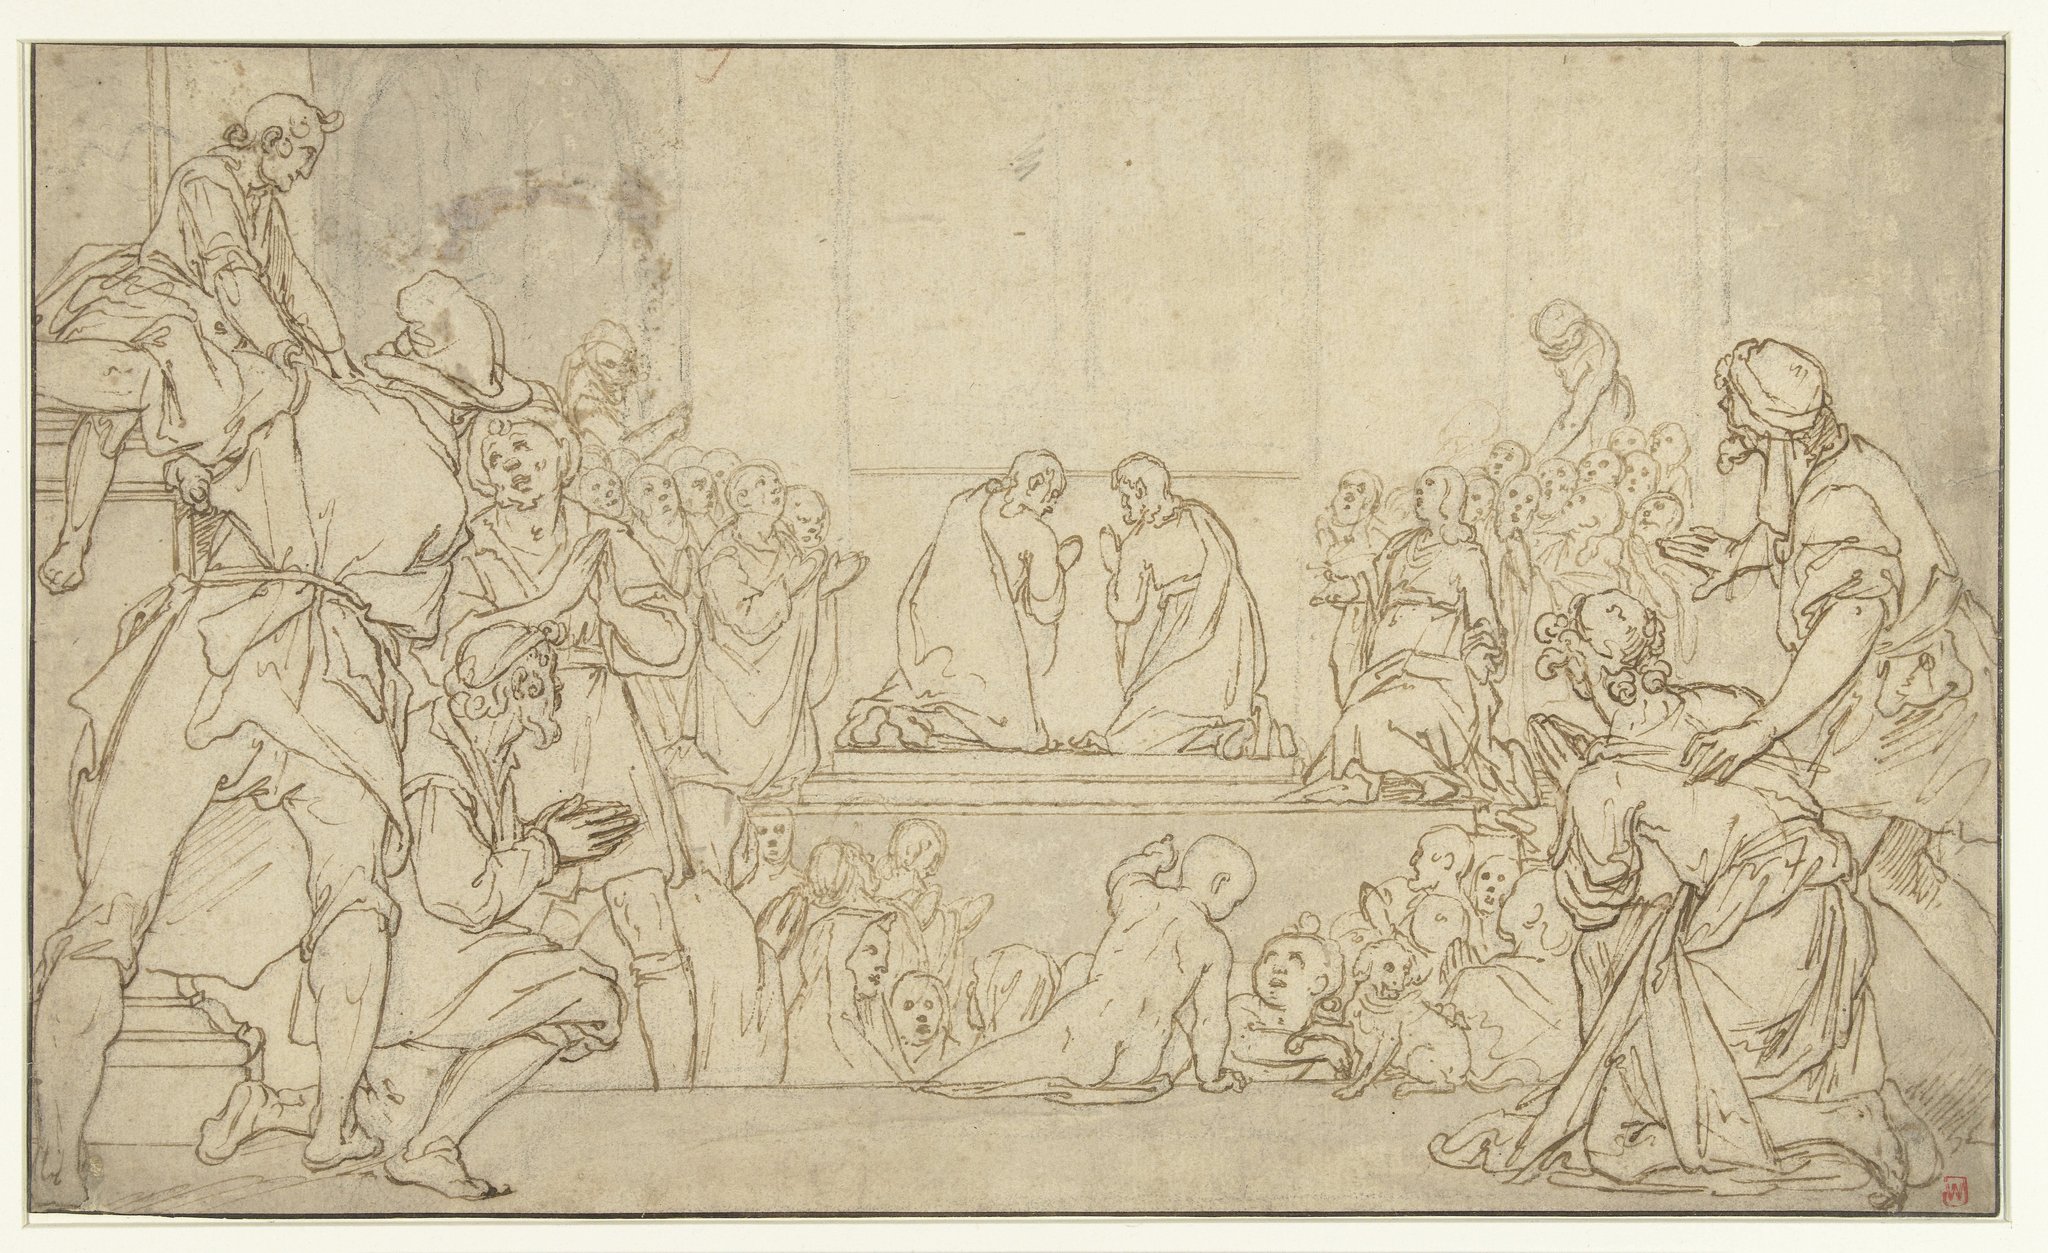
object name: drawing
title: Matthias en Barnabas in gebed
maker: Anonymous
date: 1560-1640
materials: chalk, ink, paper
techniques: brush, pen